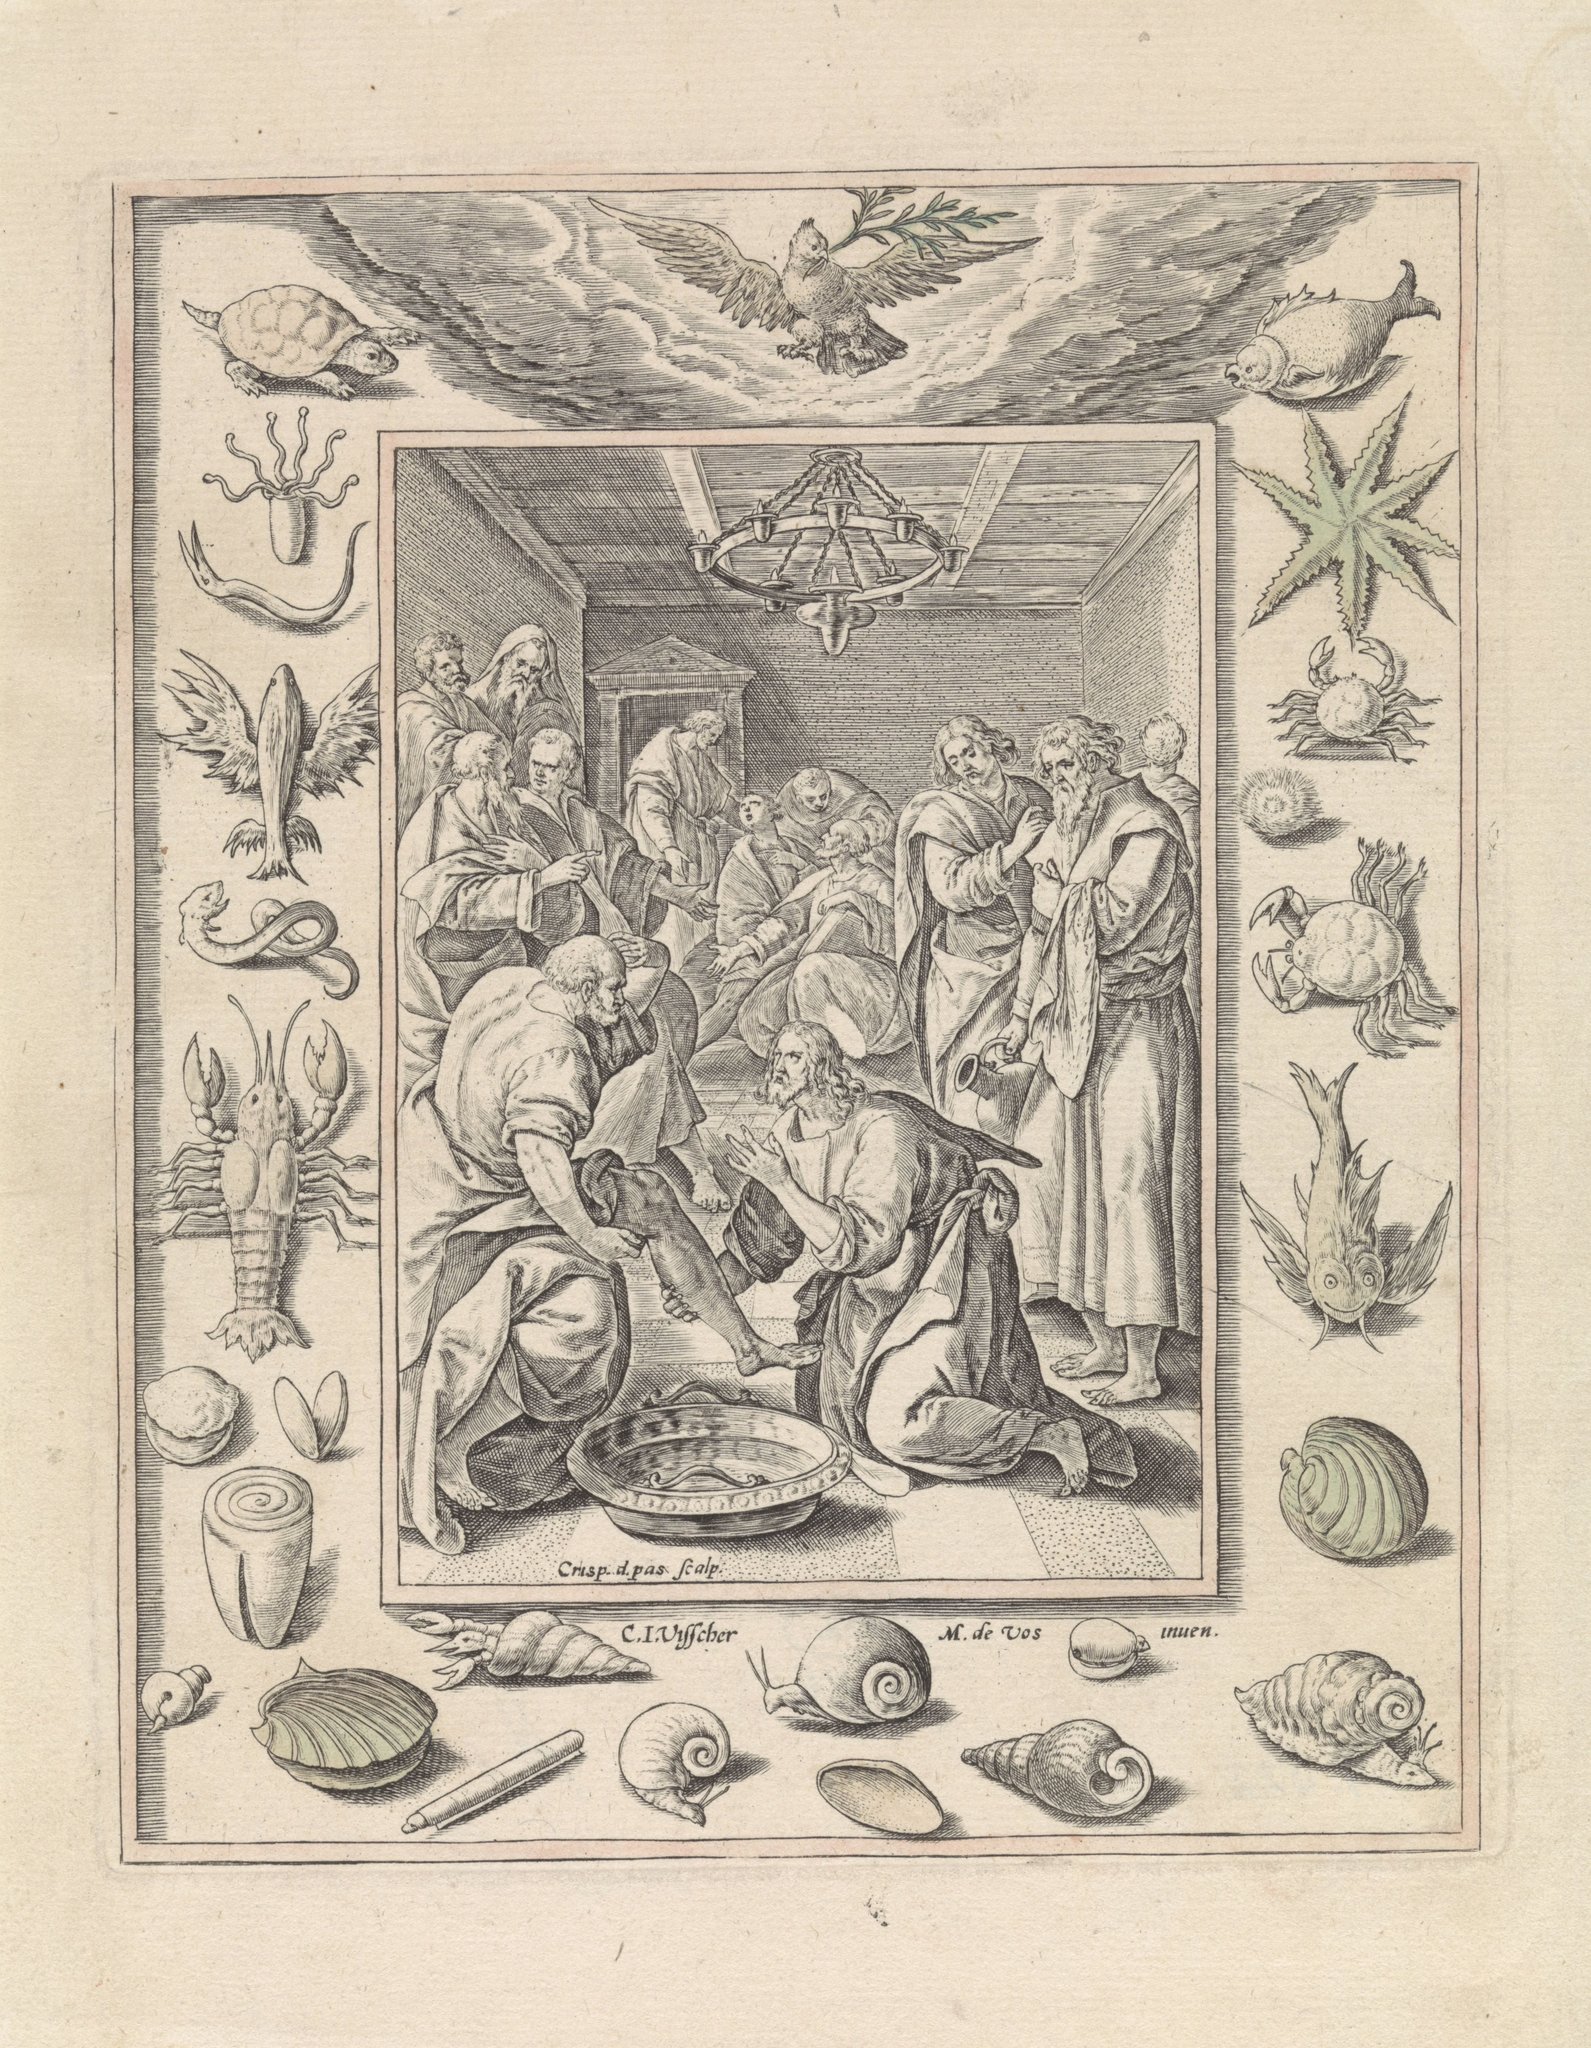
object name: print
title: Passie van Christus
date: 1580-1588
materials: paper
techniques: engraving, hand coloring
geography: antwerp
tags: christ washes peter's feet, fishes, holy ghost represented as a dove (in flames)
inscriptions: collector's mark: Lugt 2228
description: Christus wast de voeten van de apostel Petrus. De voorstelling wordt omlijst door een ornamentele rand die is versierd met schelpen en vissen, en de Heilige Geest in de vorm van een duif.